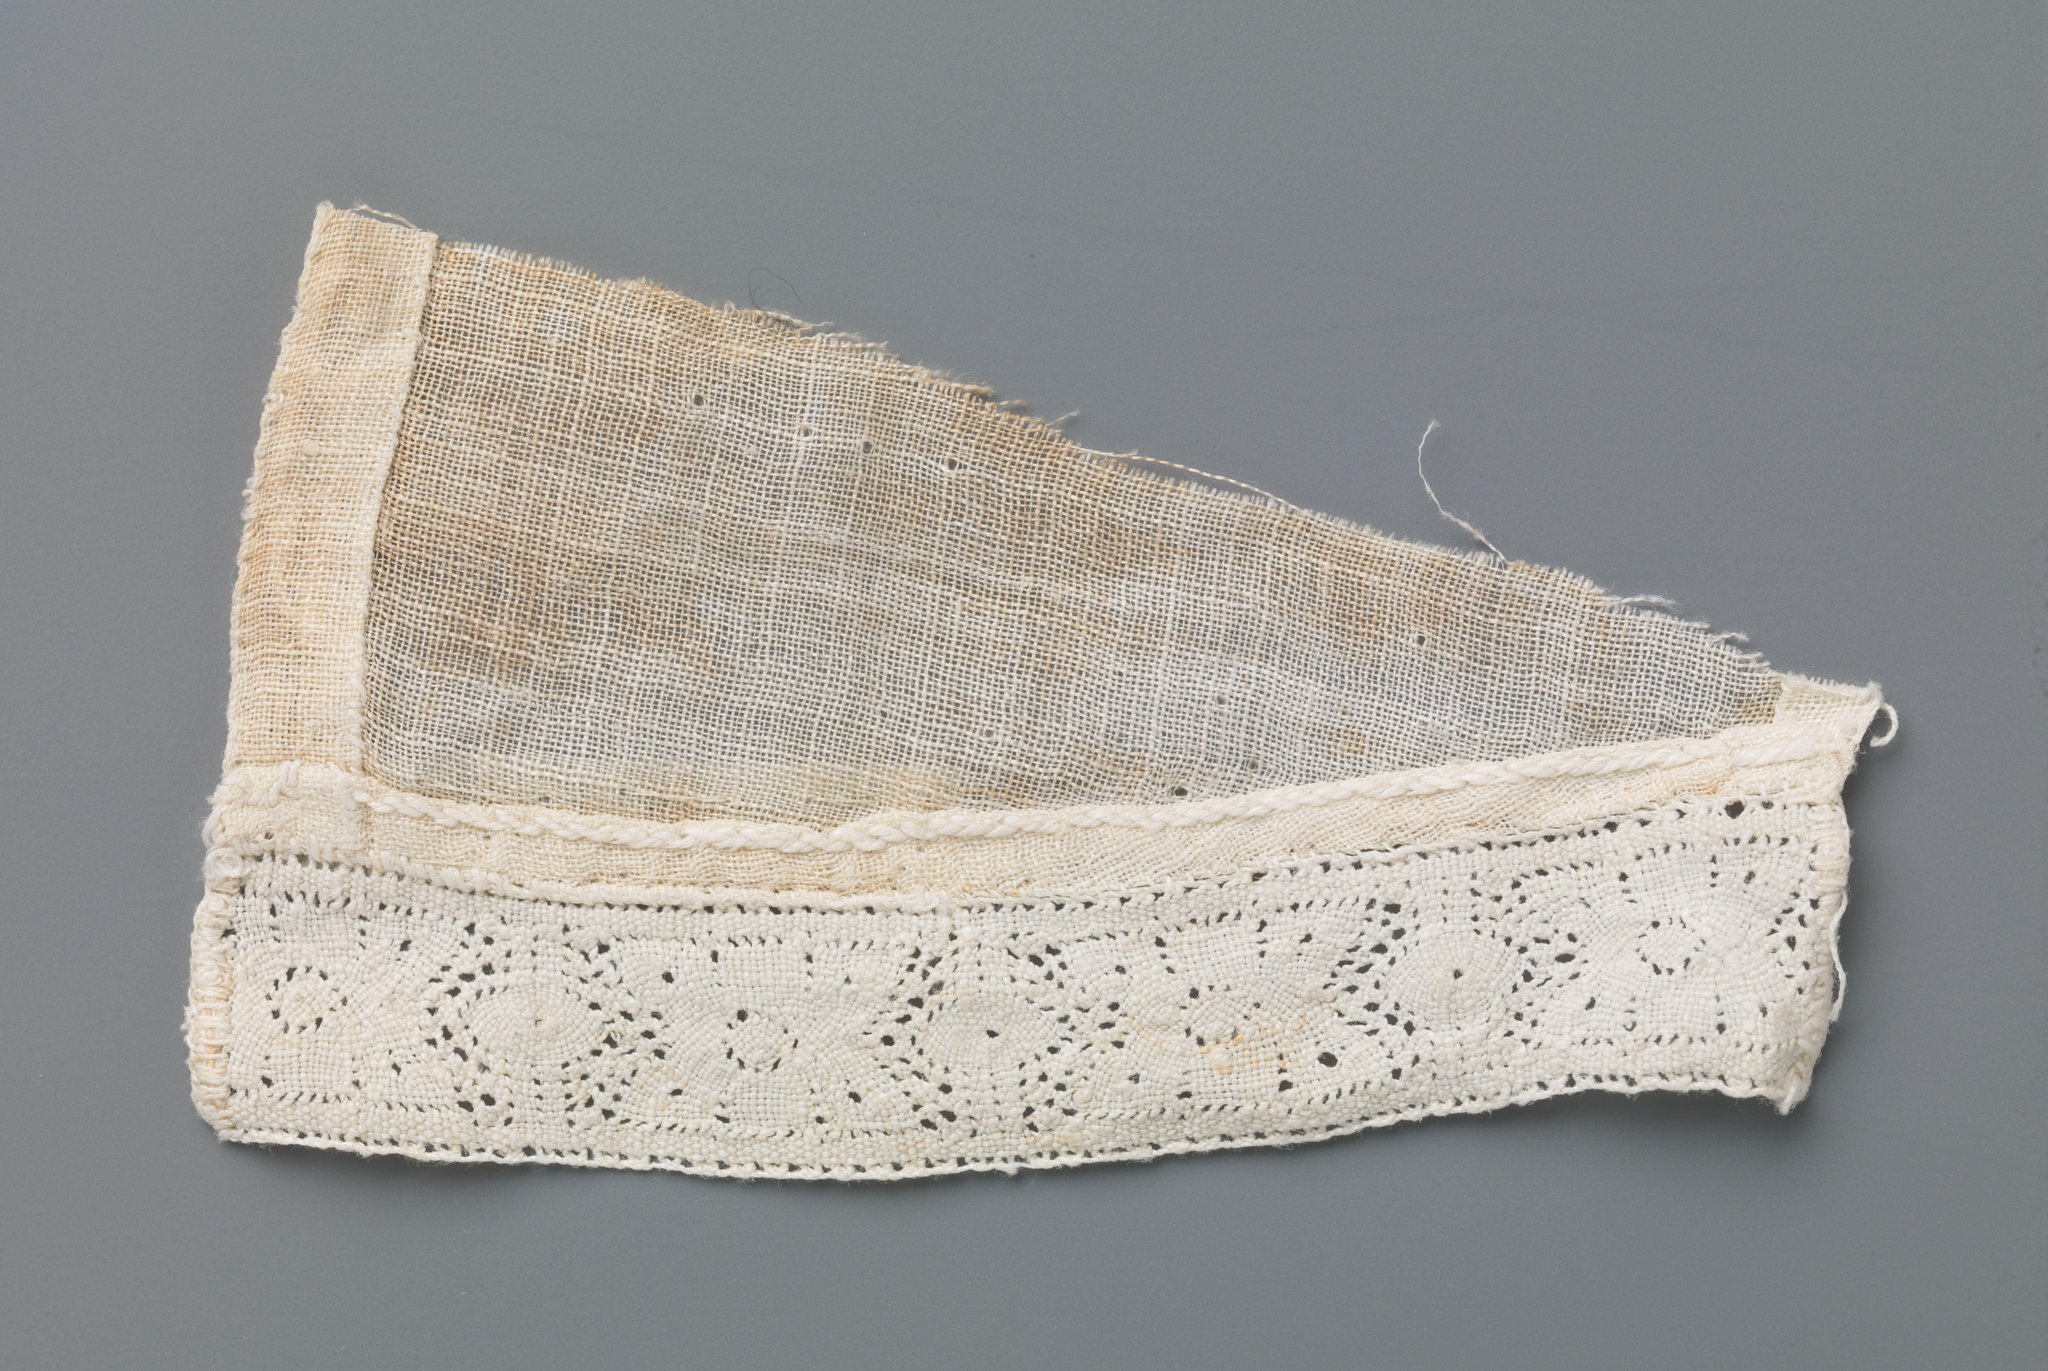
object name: strip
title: Strookje kloskant met gestileerde bloem tussen twee vertikale lijnen en ovalen aan een driehoekig fragment linnen batist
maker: Anonymous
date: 1600-1635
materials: linen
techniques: lace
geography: southern netherlands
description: Strookje naturelkleurige kloskant, oudvlaamse kant of Hollandse kloskant. Het strookje zit vast aan een driehoekig fragment linnen batist. Het kant heeft een patroon dat bestaat uit vertikale rechte lijnen, waartussen een gestileerde bloem staat. Op de middenlijn wordt de bloem links en rechts geflankeerd door een liggend spitsovaaltje, dat de vertikale lijn steeds oversnijdt. De motieven zijn gemaakt in linnenslag met uitsparingen, er is nauwelijks sprake van een grond, de motieven zijn door zeer korte vlechtjes met elkaar verbonden. Boven- en onderzijde van het strookje zijn afgewerkt met een rechte rand.